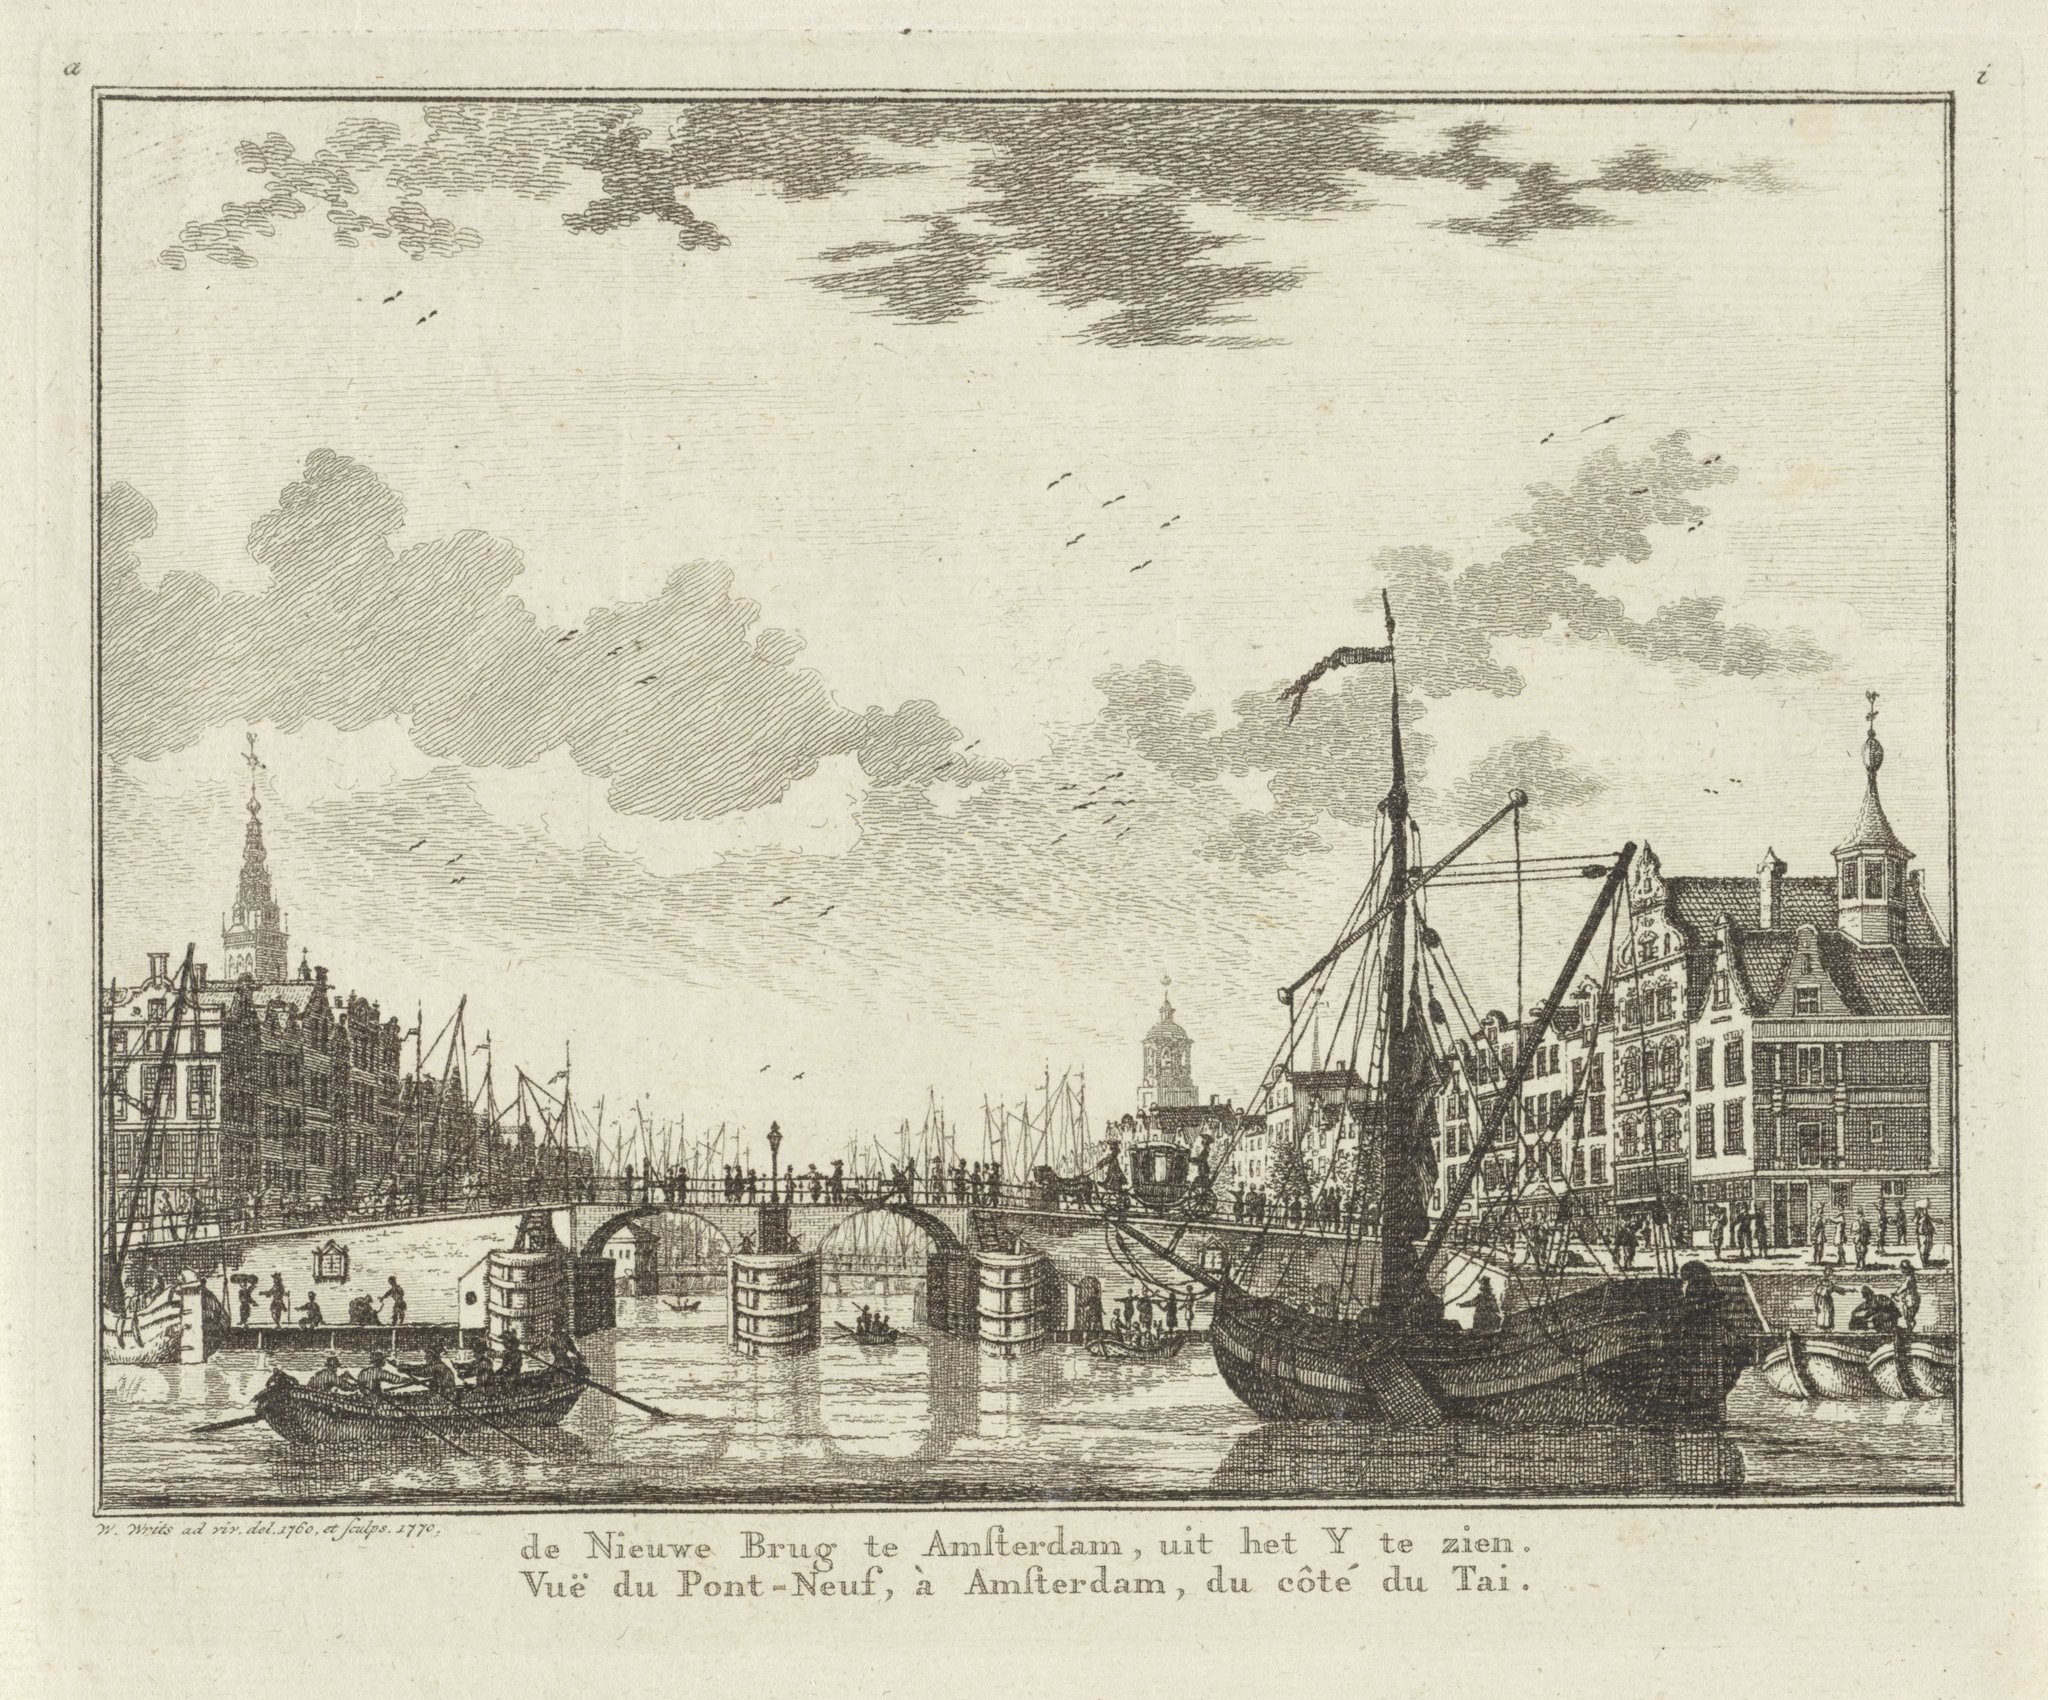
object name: print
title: Gezicht op de Nieuwe Brug te Amsterdam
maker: willem writs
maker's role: draughtsman, print maker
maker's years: 1731-1786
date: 1770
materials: paper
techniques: etching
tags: rowing-boat, canoe, etc.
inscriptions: collector's mark: Lugt 2228